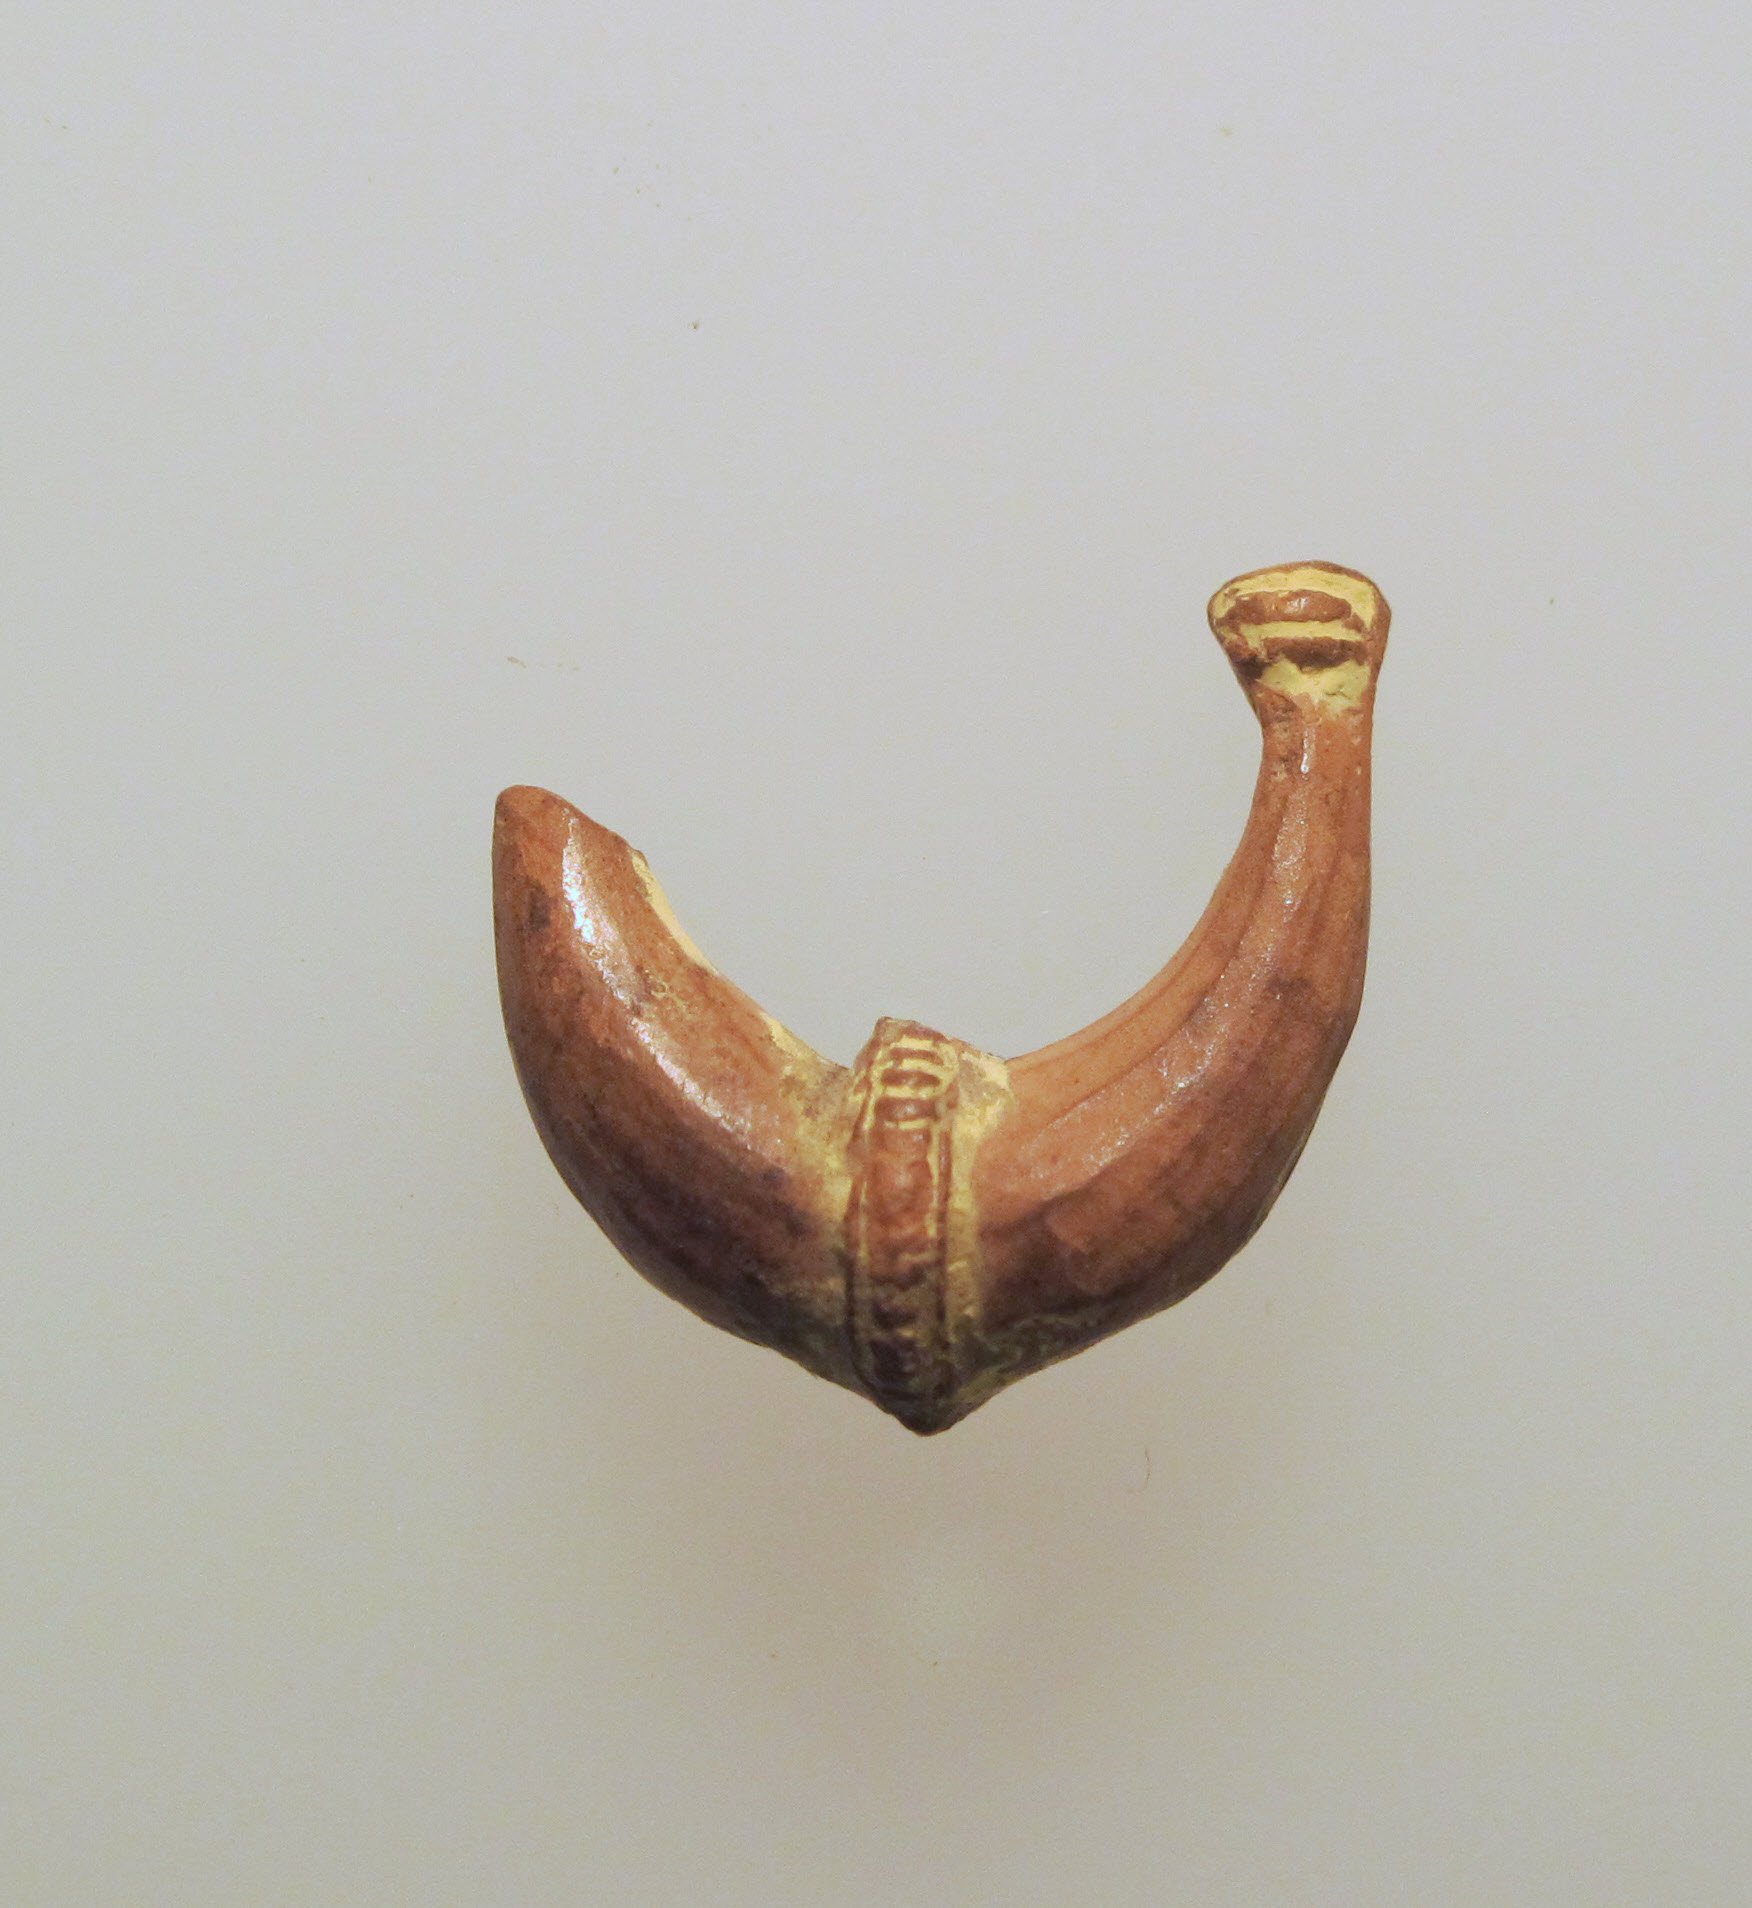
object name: earring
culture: cypriot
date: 3900 BCE-100 CE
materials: terracotta